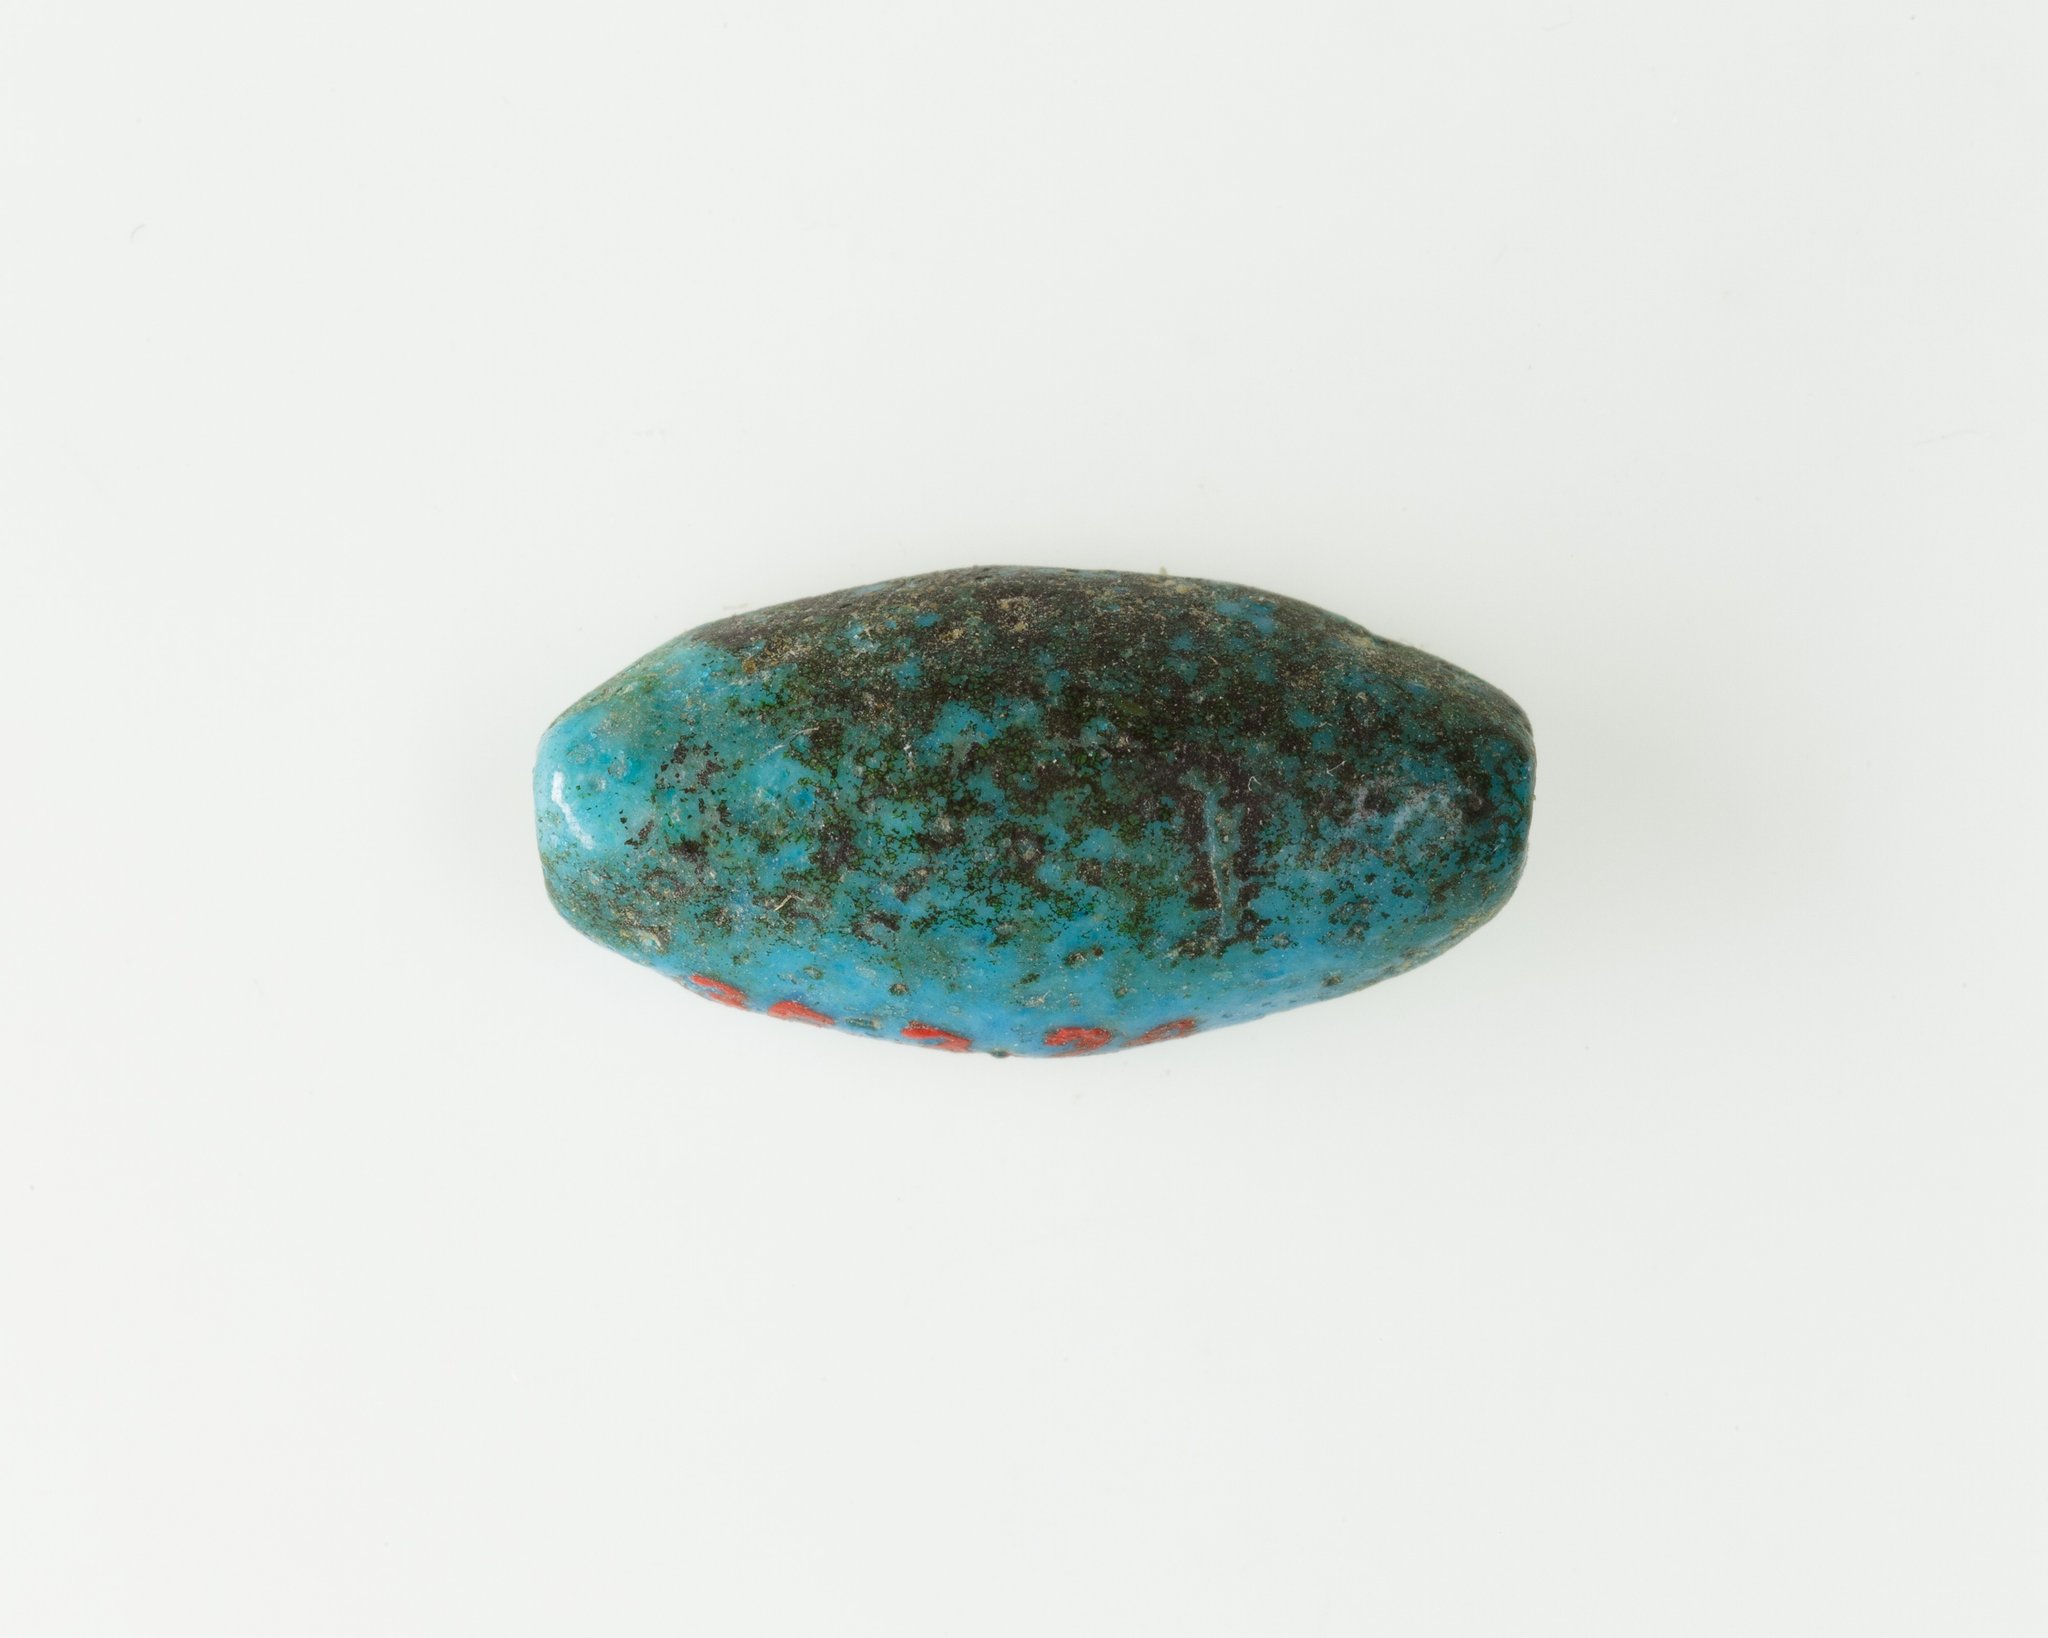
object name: cowroid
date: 1492-1473 BCE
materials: faience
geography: egypt